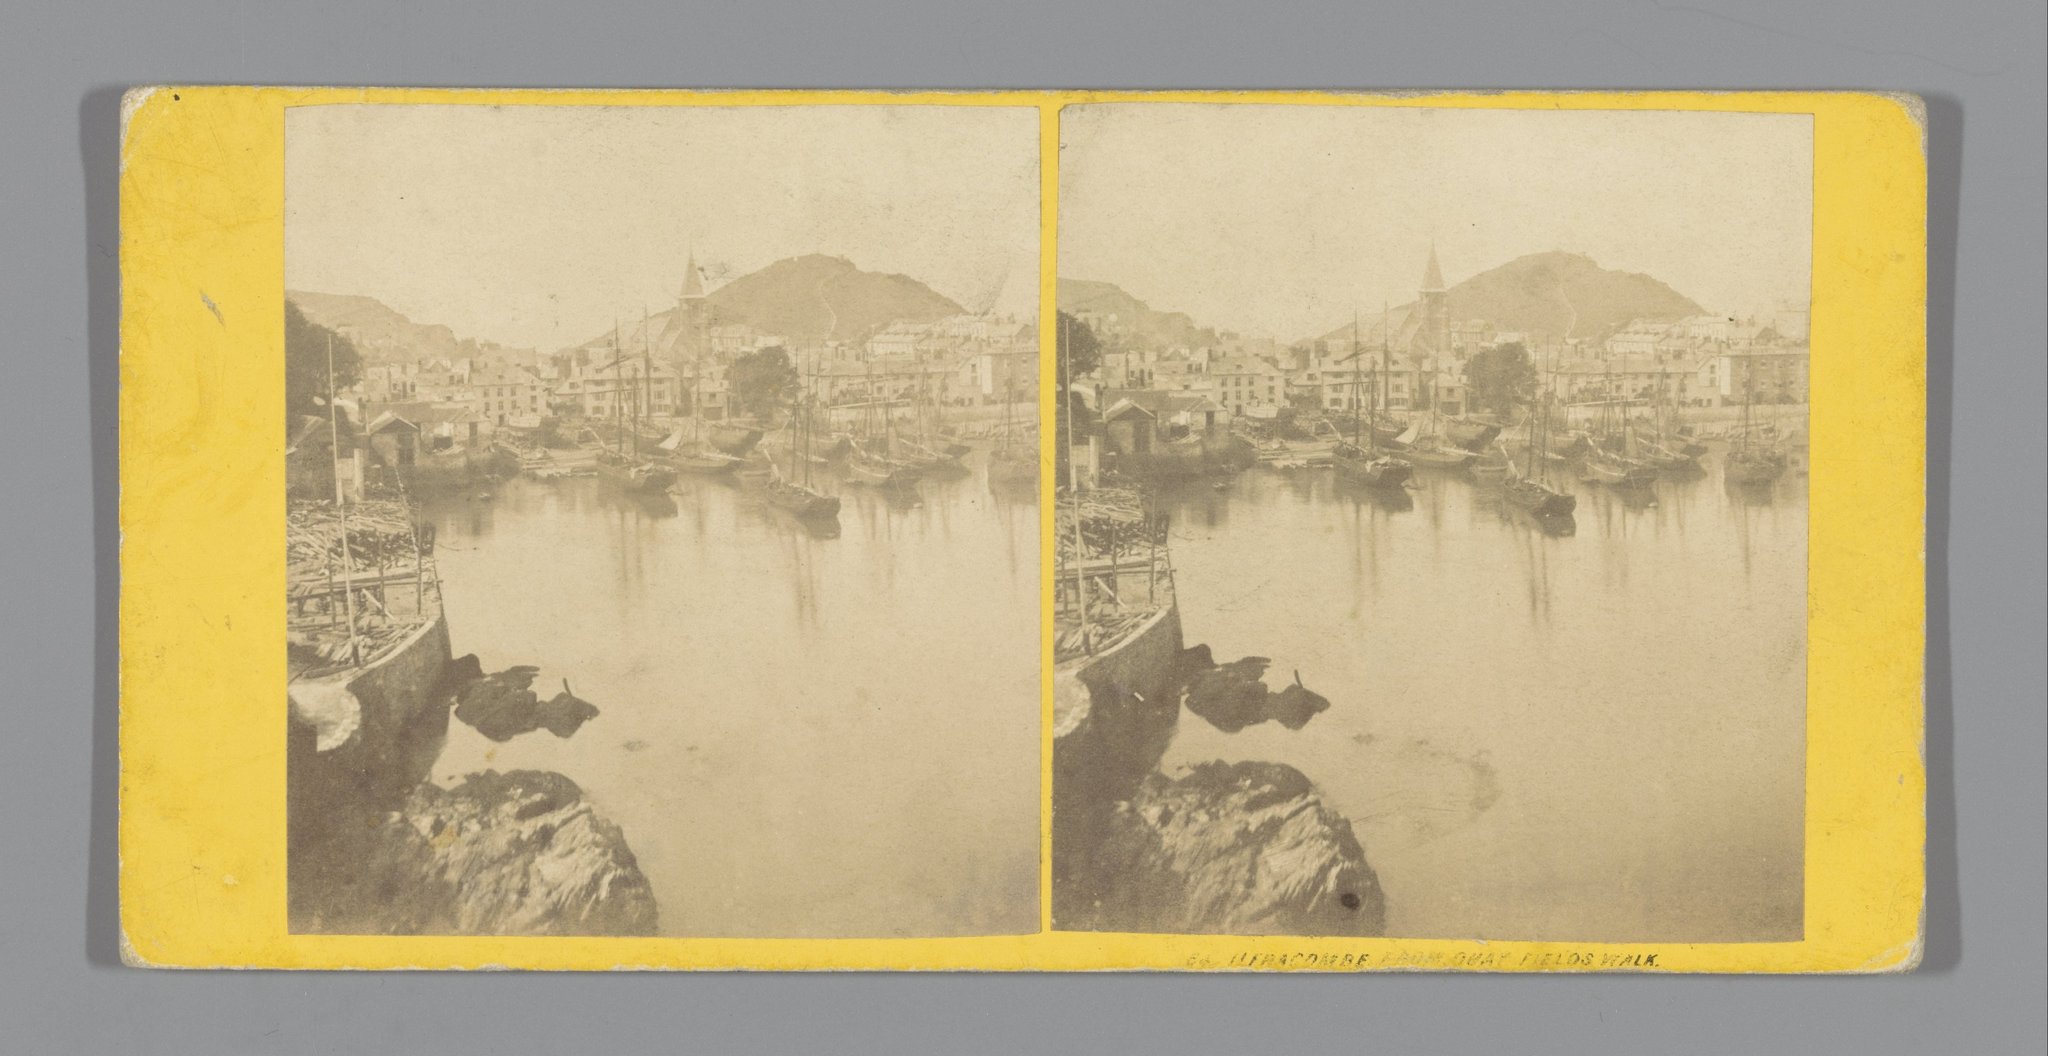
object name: stereograph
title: Ilfracombe from Quay Fields Walk.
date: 1850-1880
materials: cardboard, photographic support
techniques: albumen print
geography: exeter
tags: harbour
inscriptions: number: ‘64.’, name: ‘William Spreat, Publisher, 229, High Street, Exeter’